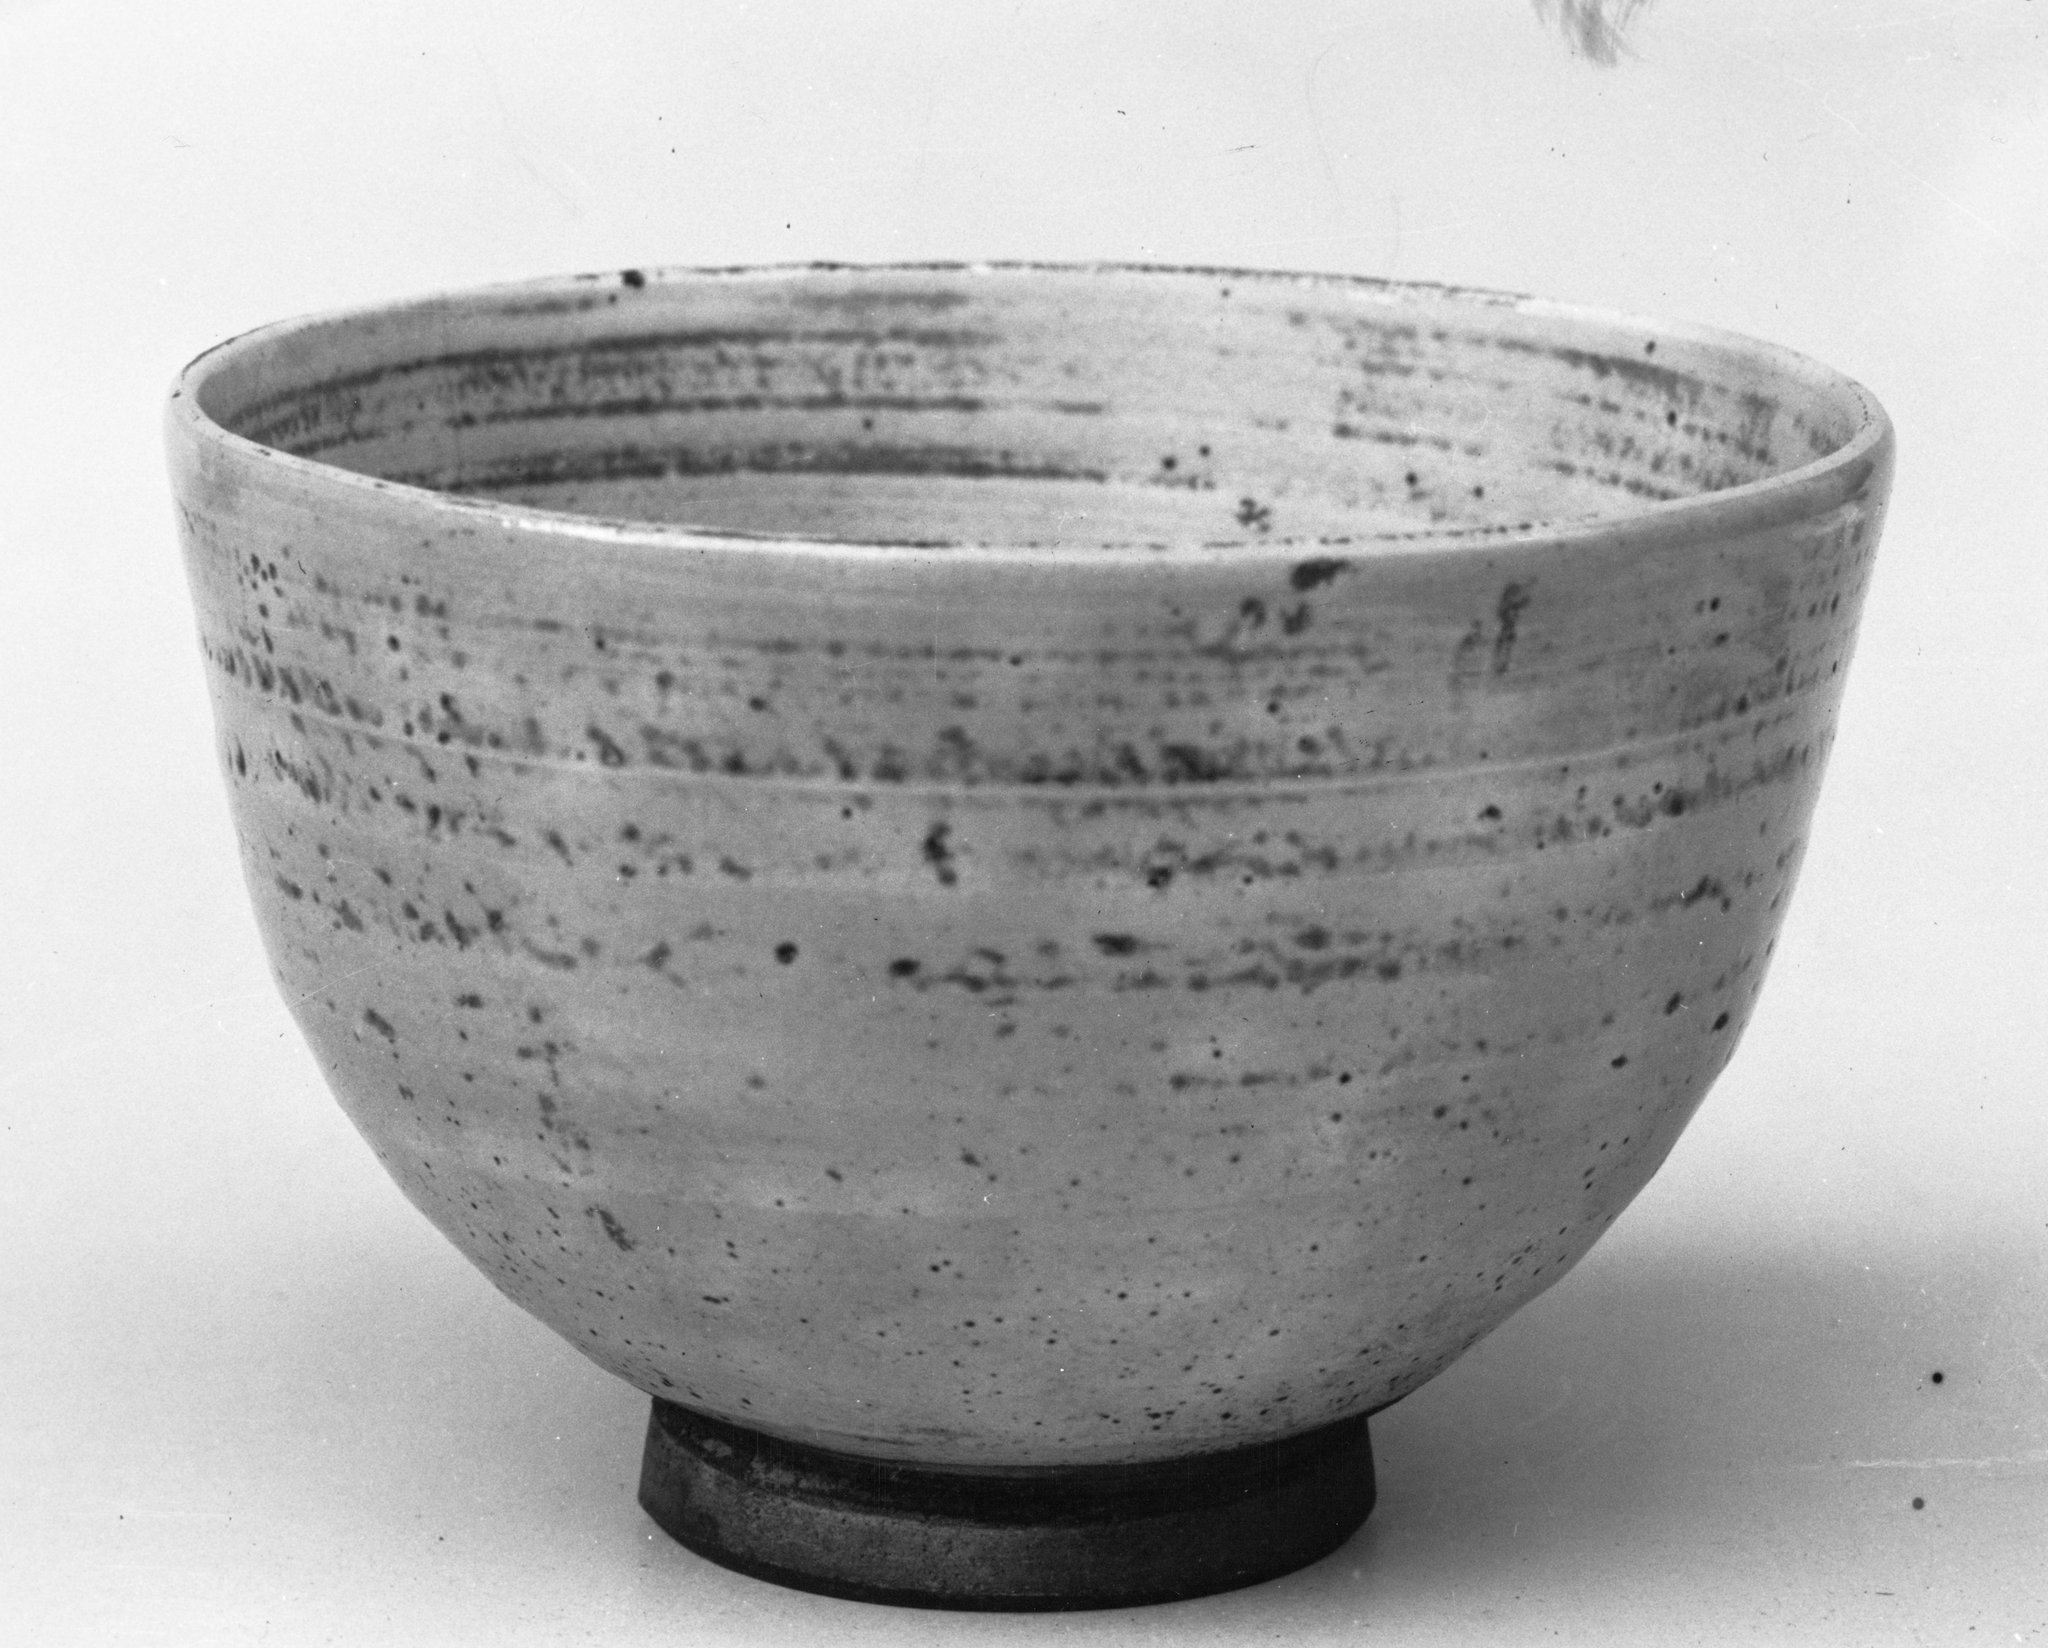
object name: teabowl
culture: japanese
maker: nin'ami dōhachi (takahashi dōhachi ii)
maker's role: artist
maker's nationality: japanese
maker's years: 1783-1855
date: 1850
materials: clay, glaze